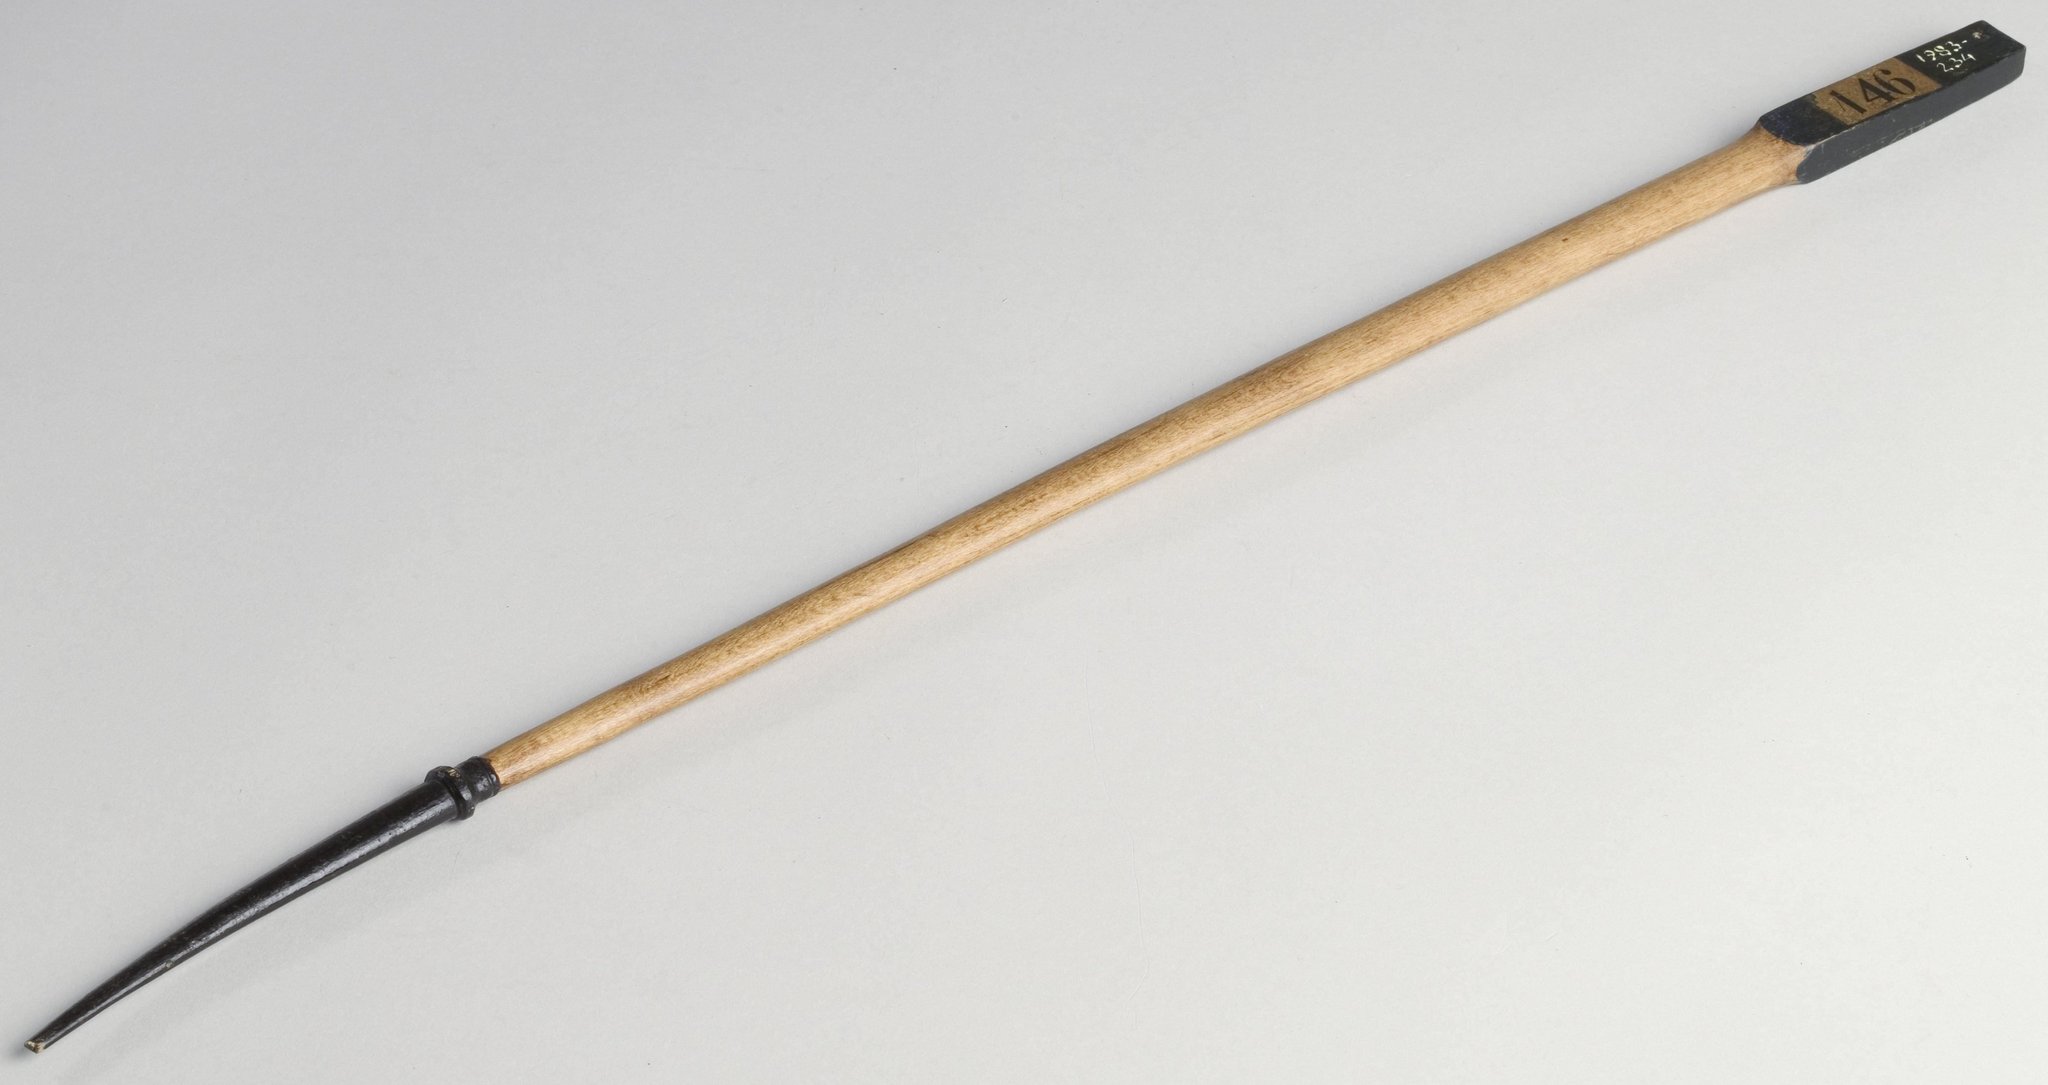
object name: demonstration model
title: Model of a Mast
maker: Anonymous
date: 1800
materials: paint, wood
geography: netherlands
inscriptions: label: ‘146’ former inventory label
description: Model van een ellipsvormige mast. In doorsnede is deze mast druppelvormig met de scherpe kant achter. Boven de hommer is de mast naar voren gebogen en loopt uit in een punt. De mastvoet is rechthoekig.